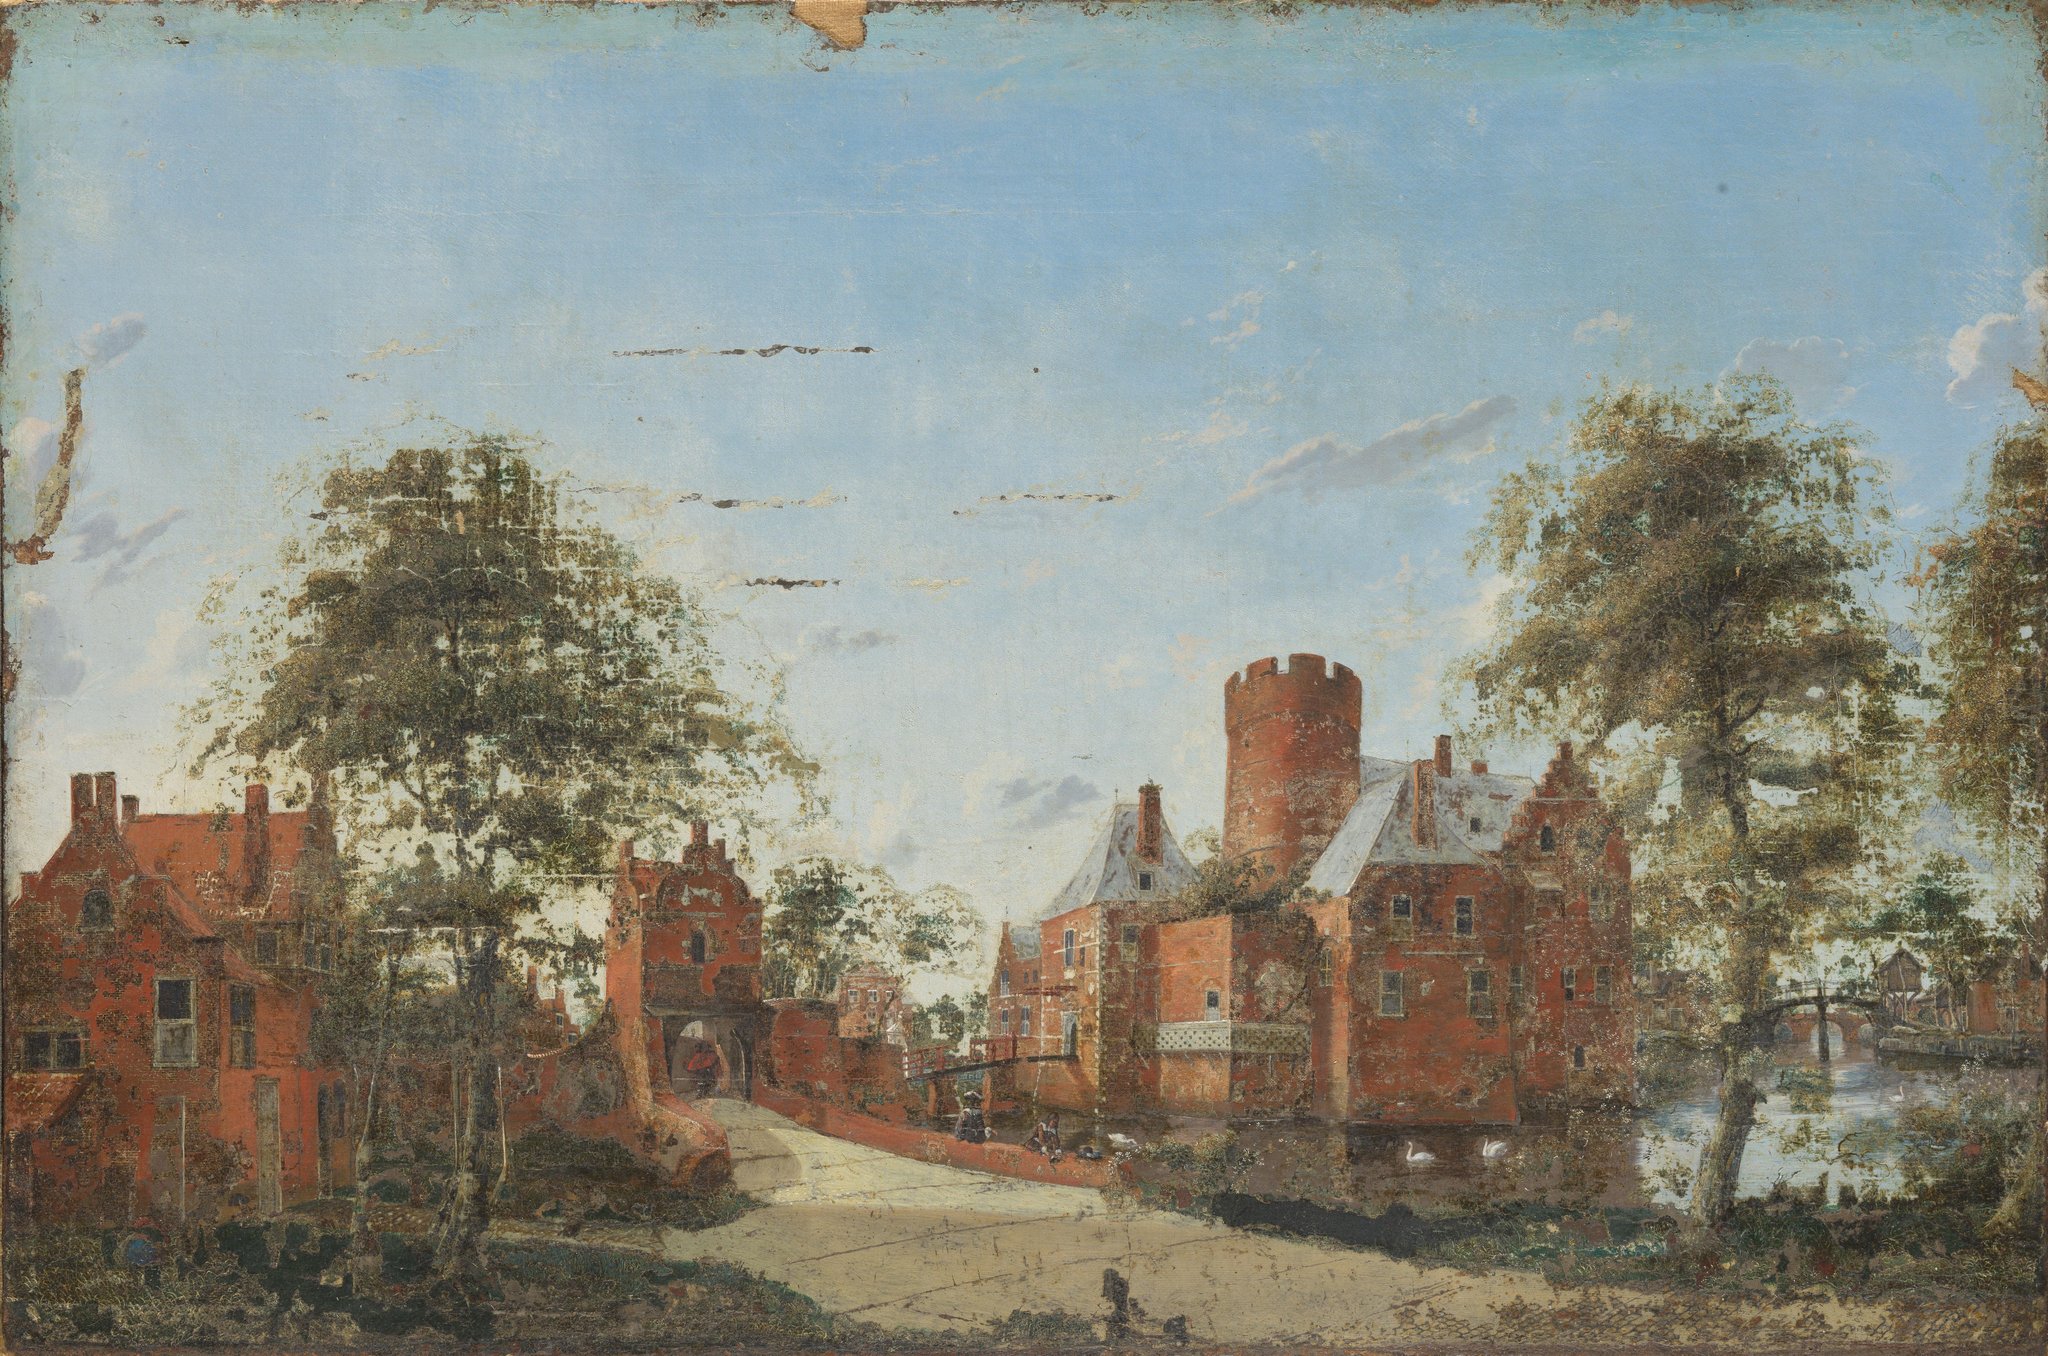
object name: painting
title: Loenersloot Castle on the Angstel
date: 1650-1750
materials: canvas, oil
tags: angstel, loenersloot, kasteel loenersloot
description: Kasteel Loenersloot aan de Angstel, links de huizen van een dorp en in het midden het poortgebouw.